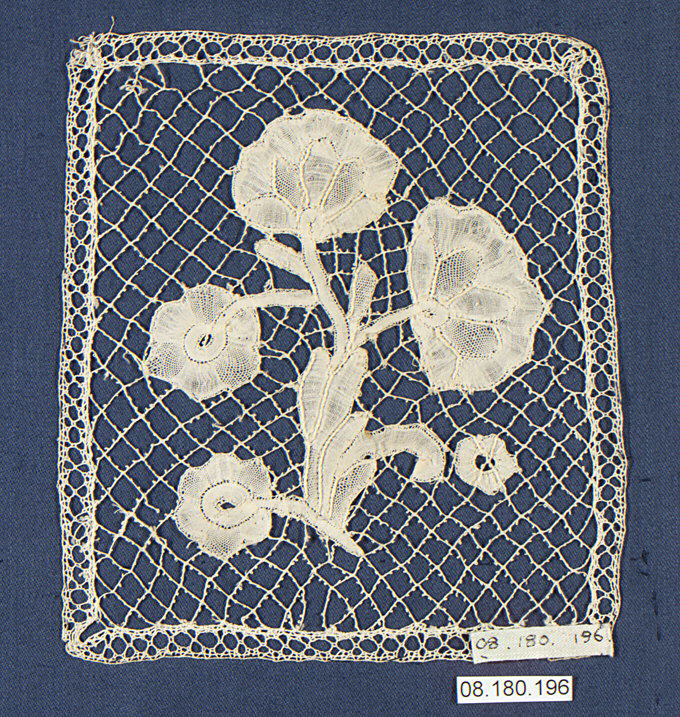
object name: square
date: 1801-1900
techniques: lace